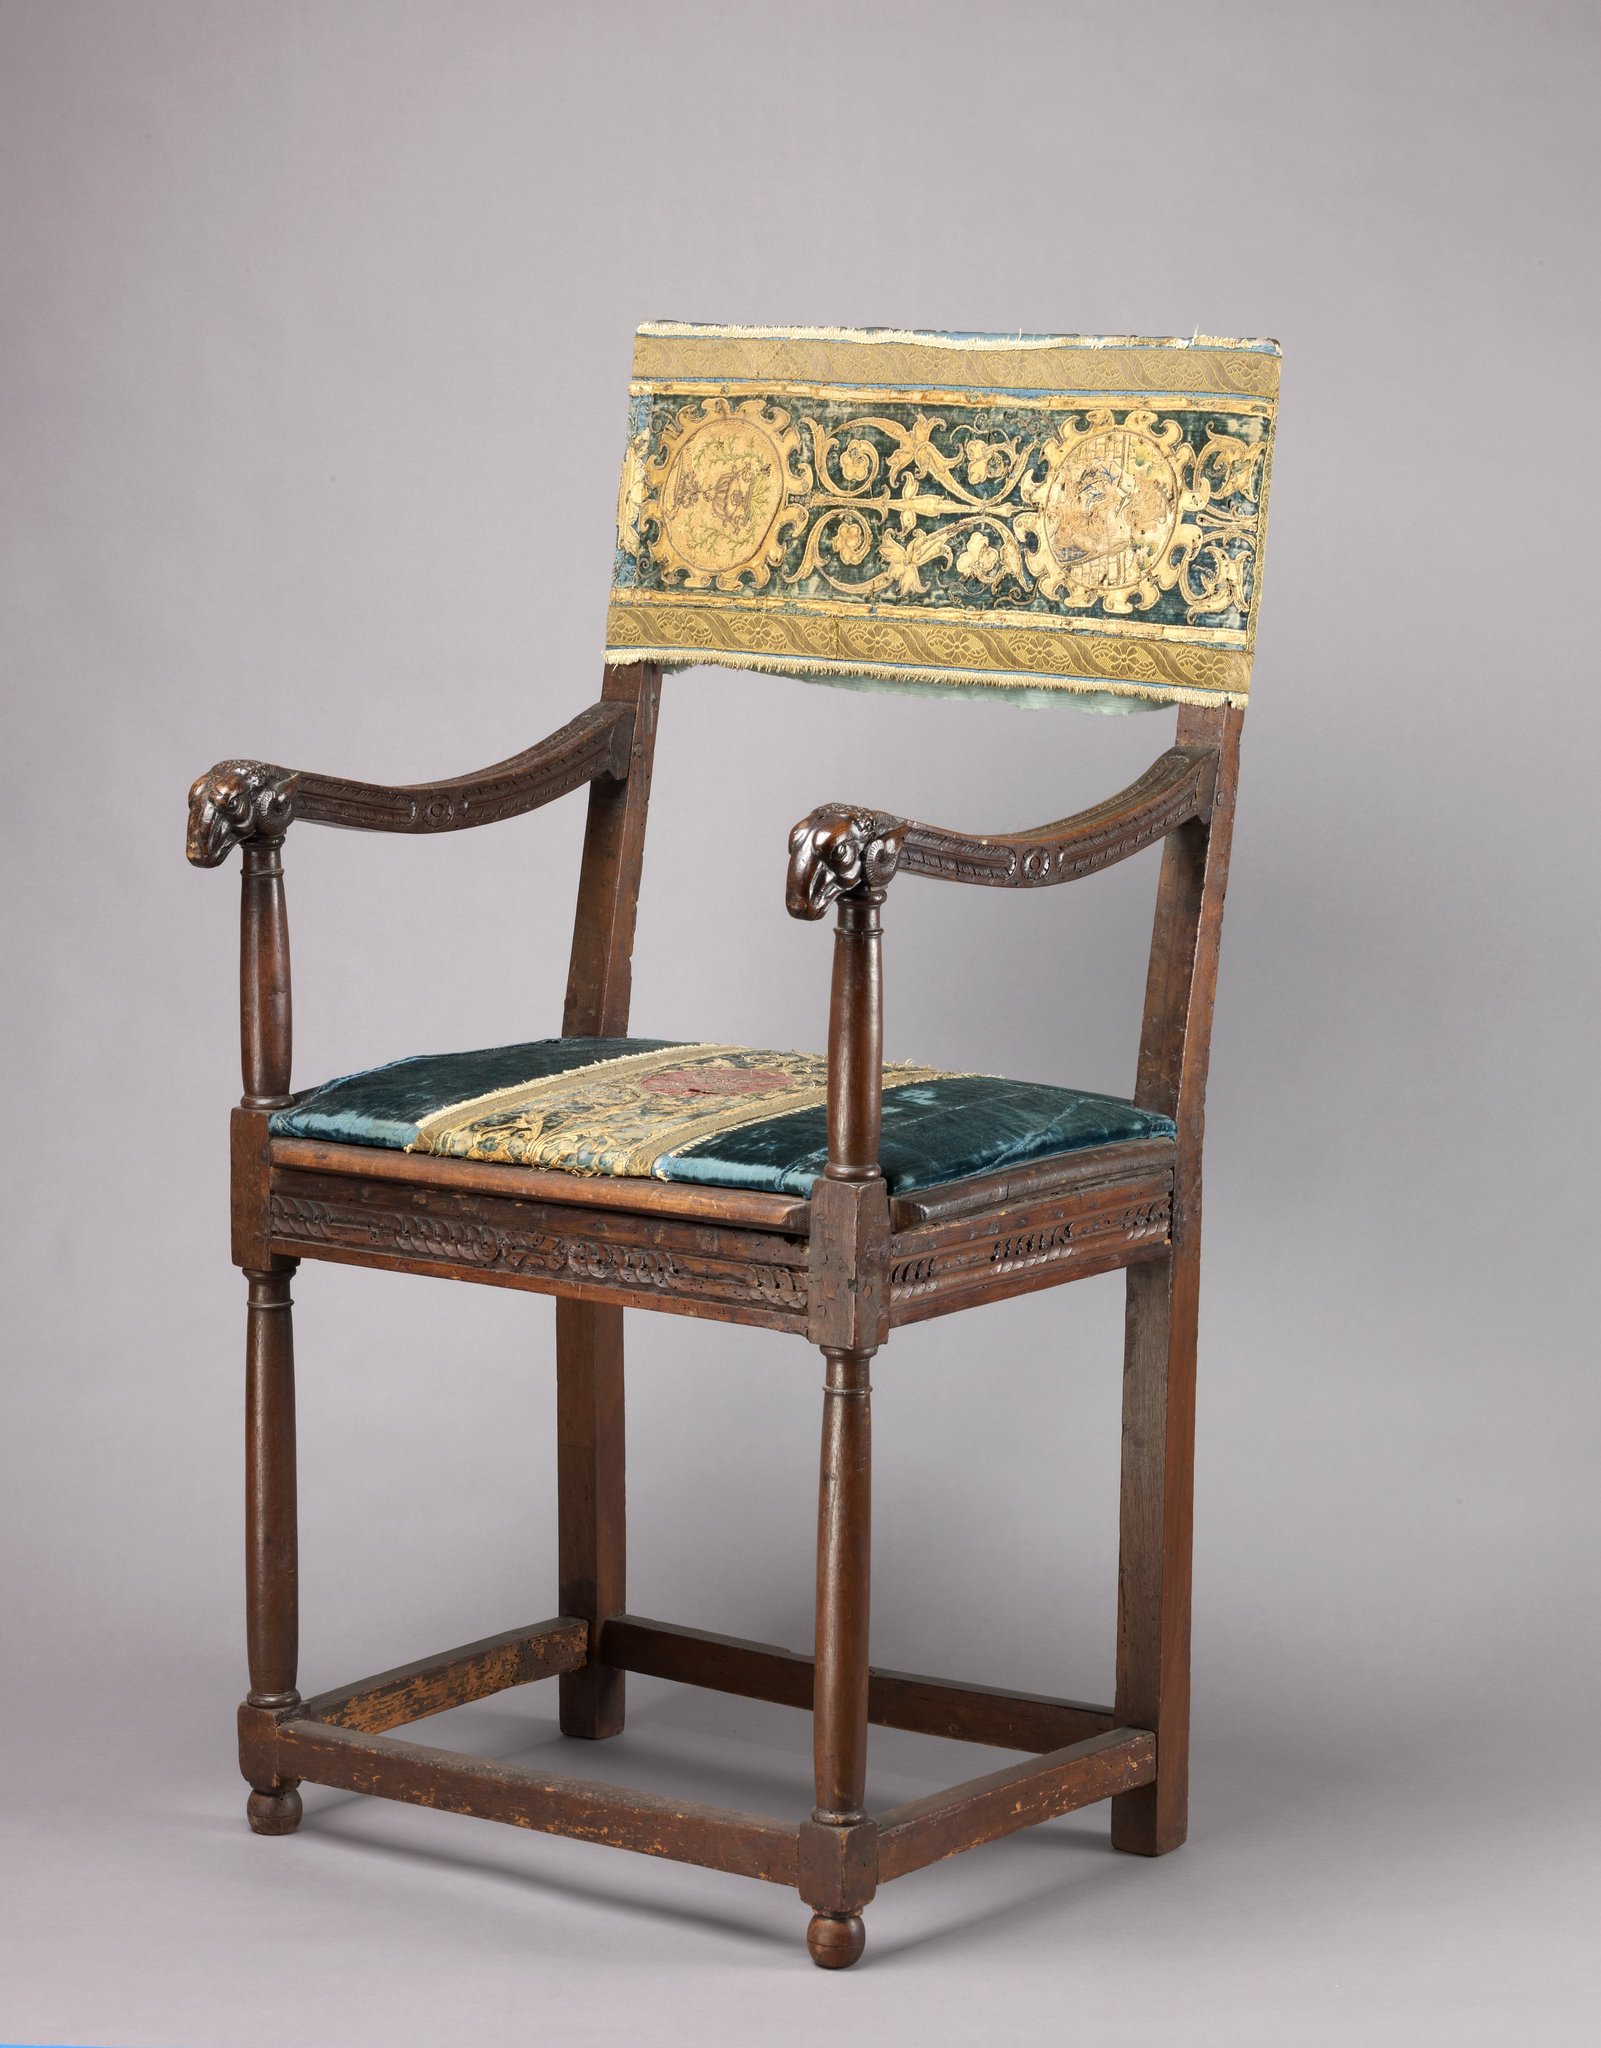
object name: armchair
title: Armchair (chaise à bras, pair with 1975.1.2000)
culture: french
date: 1501-1600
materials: silk, velvet, wood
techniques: carving, cutting, embroidery